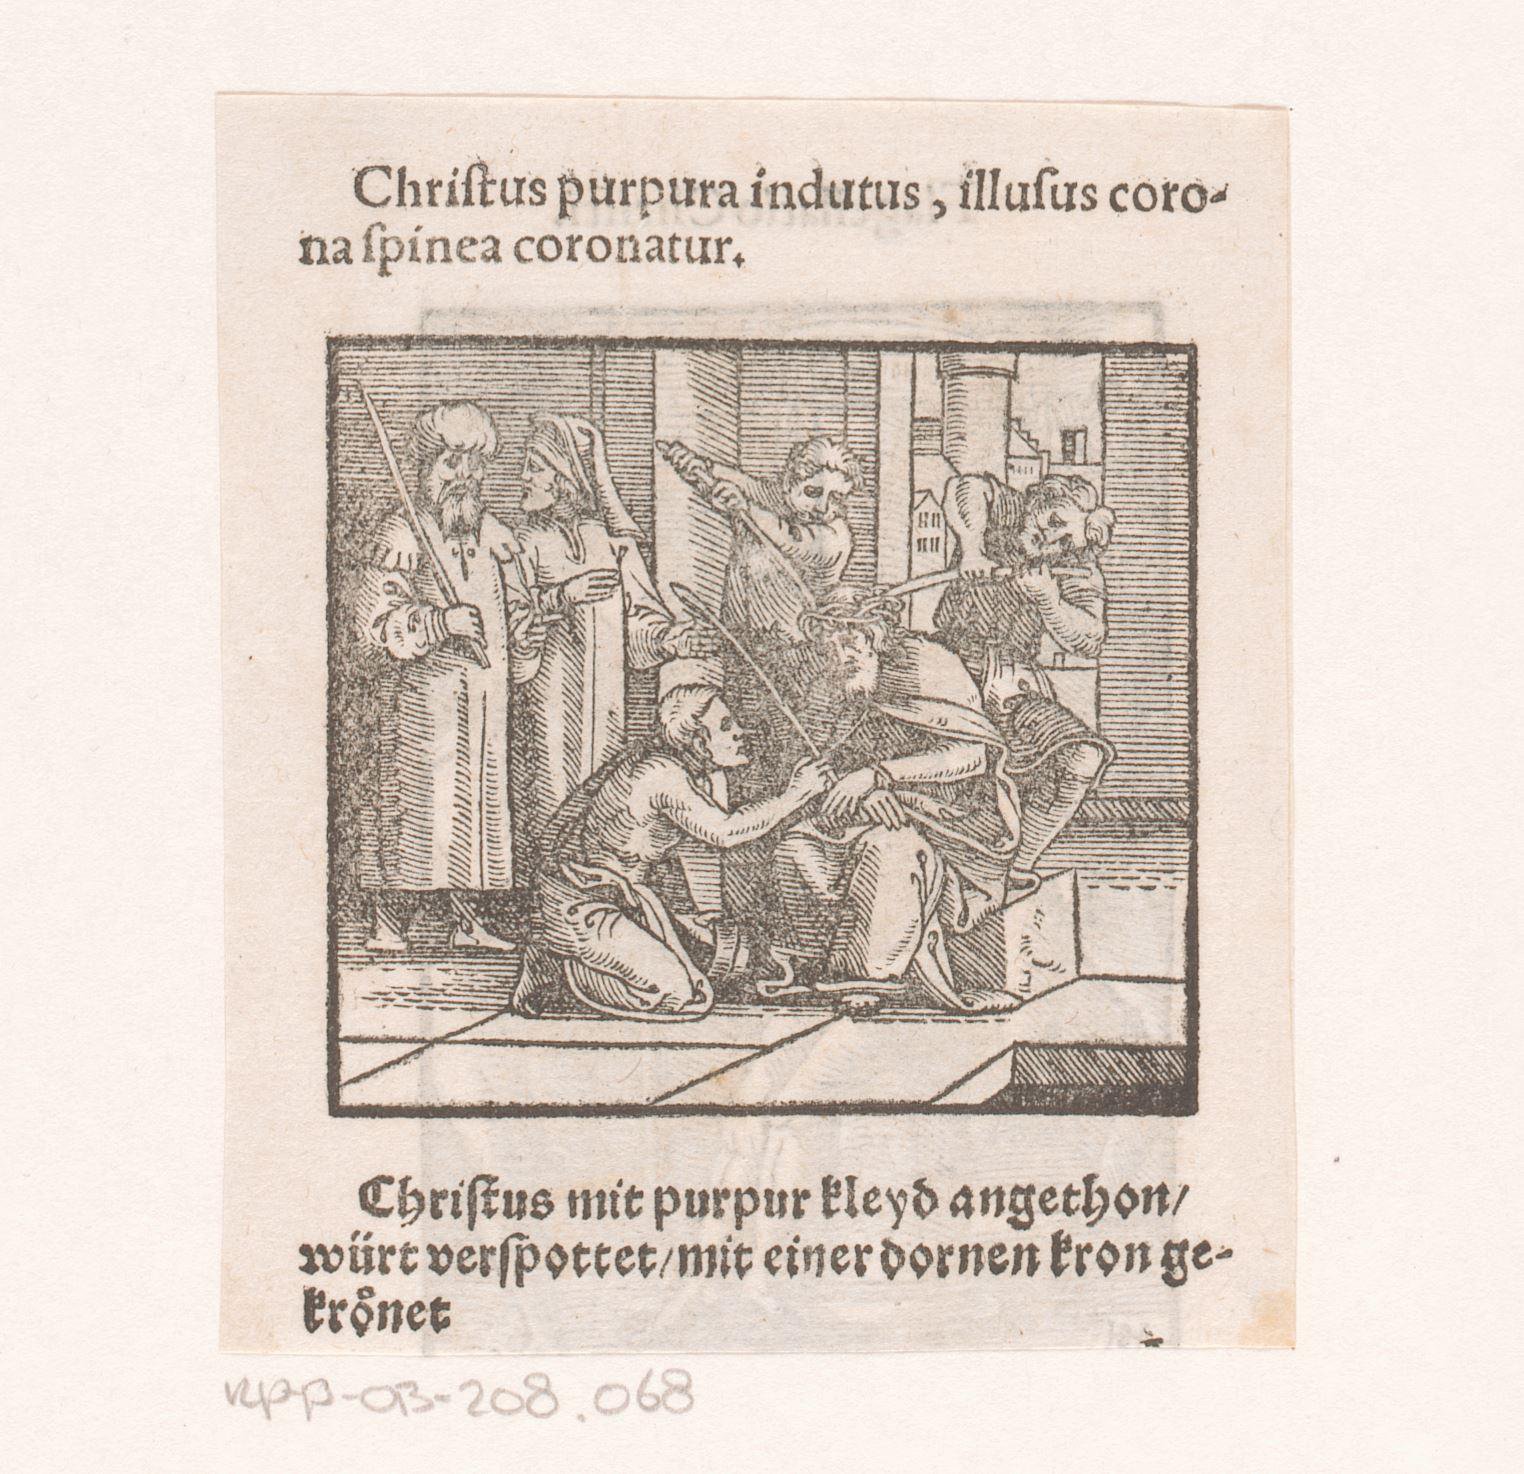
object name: book illustration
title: Doornenkroning van Christus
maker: Anonymous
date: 1600-1699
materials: paper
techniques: letterpress printing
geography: netherlands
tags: the crowning with thorns: soldiers with sticks place a thorny crown on christ's head and give him a reed (matthew 27:27-31; mark 15:16-20; john 19:2-3)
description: Twee mannen zetten Christus met stokken een doornenkroon op het hoofd. Een man knielt voor hem en geeft hem een rietstok in de hand.